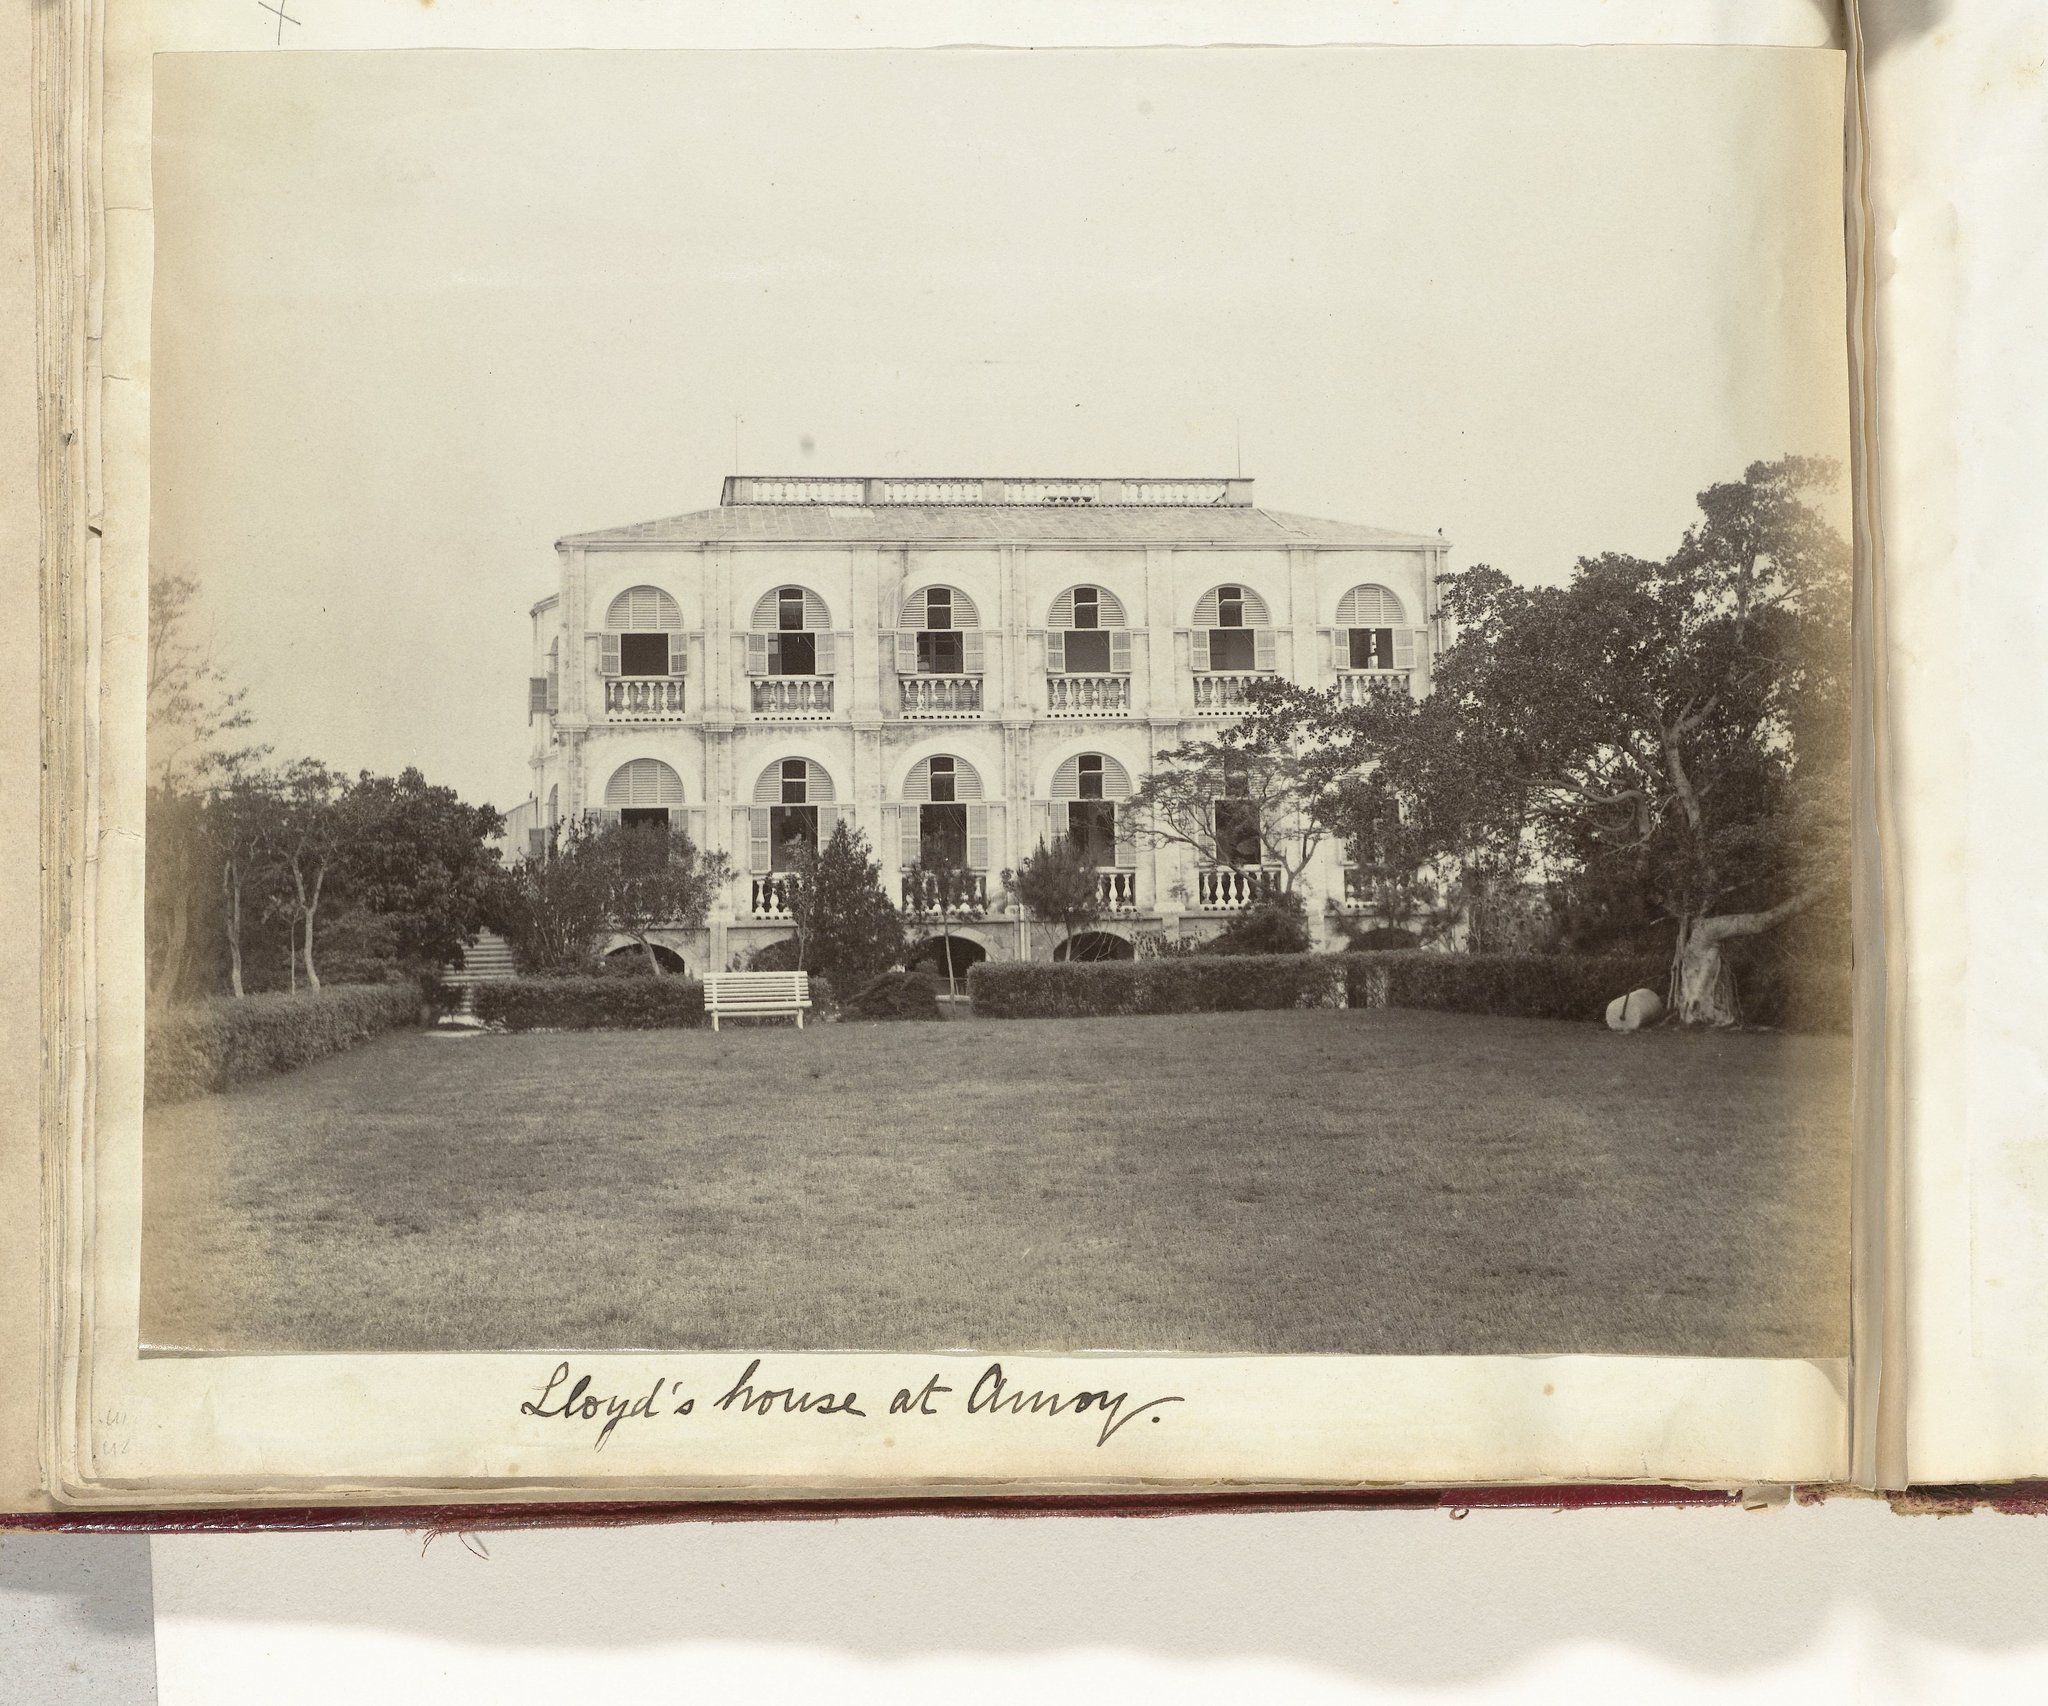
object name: album leaf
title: Lloyd's house at Amoy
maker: Anonymous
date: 1879-1890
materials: paper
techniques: albumen print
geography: xiamen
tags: garden, villa